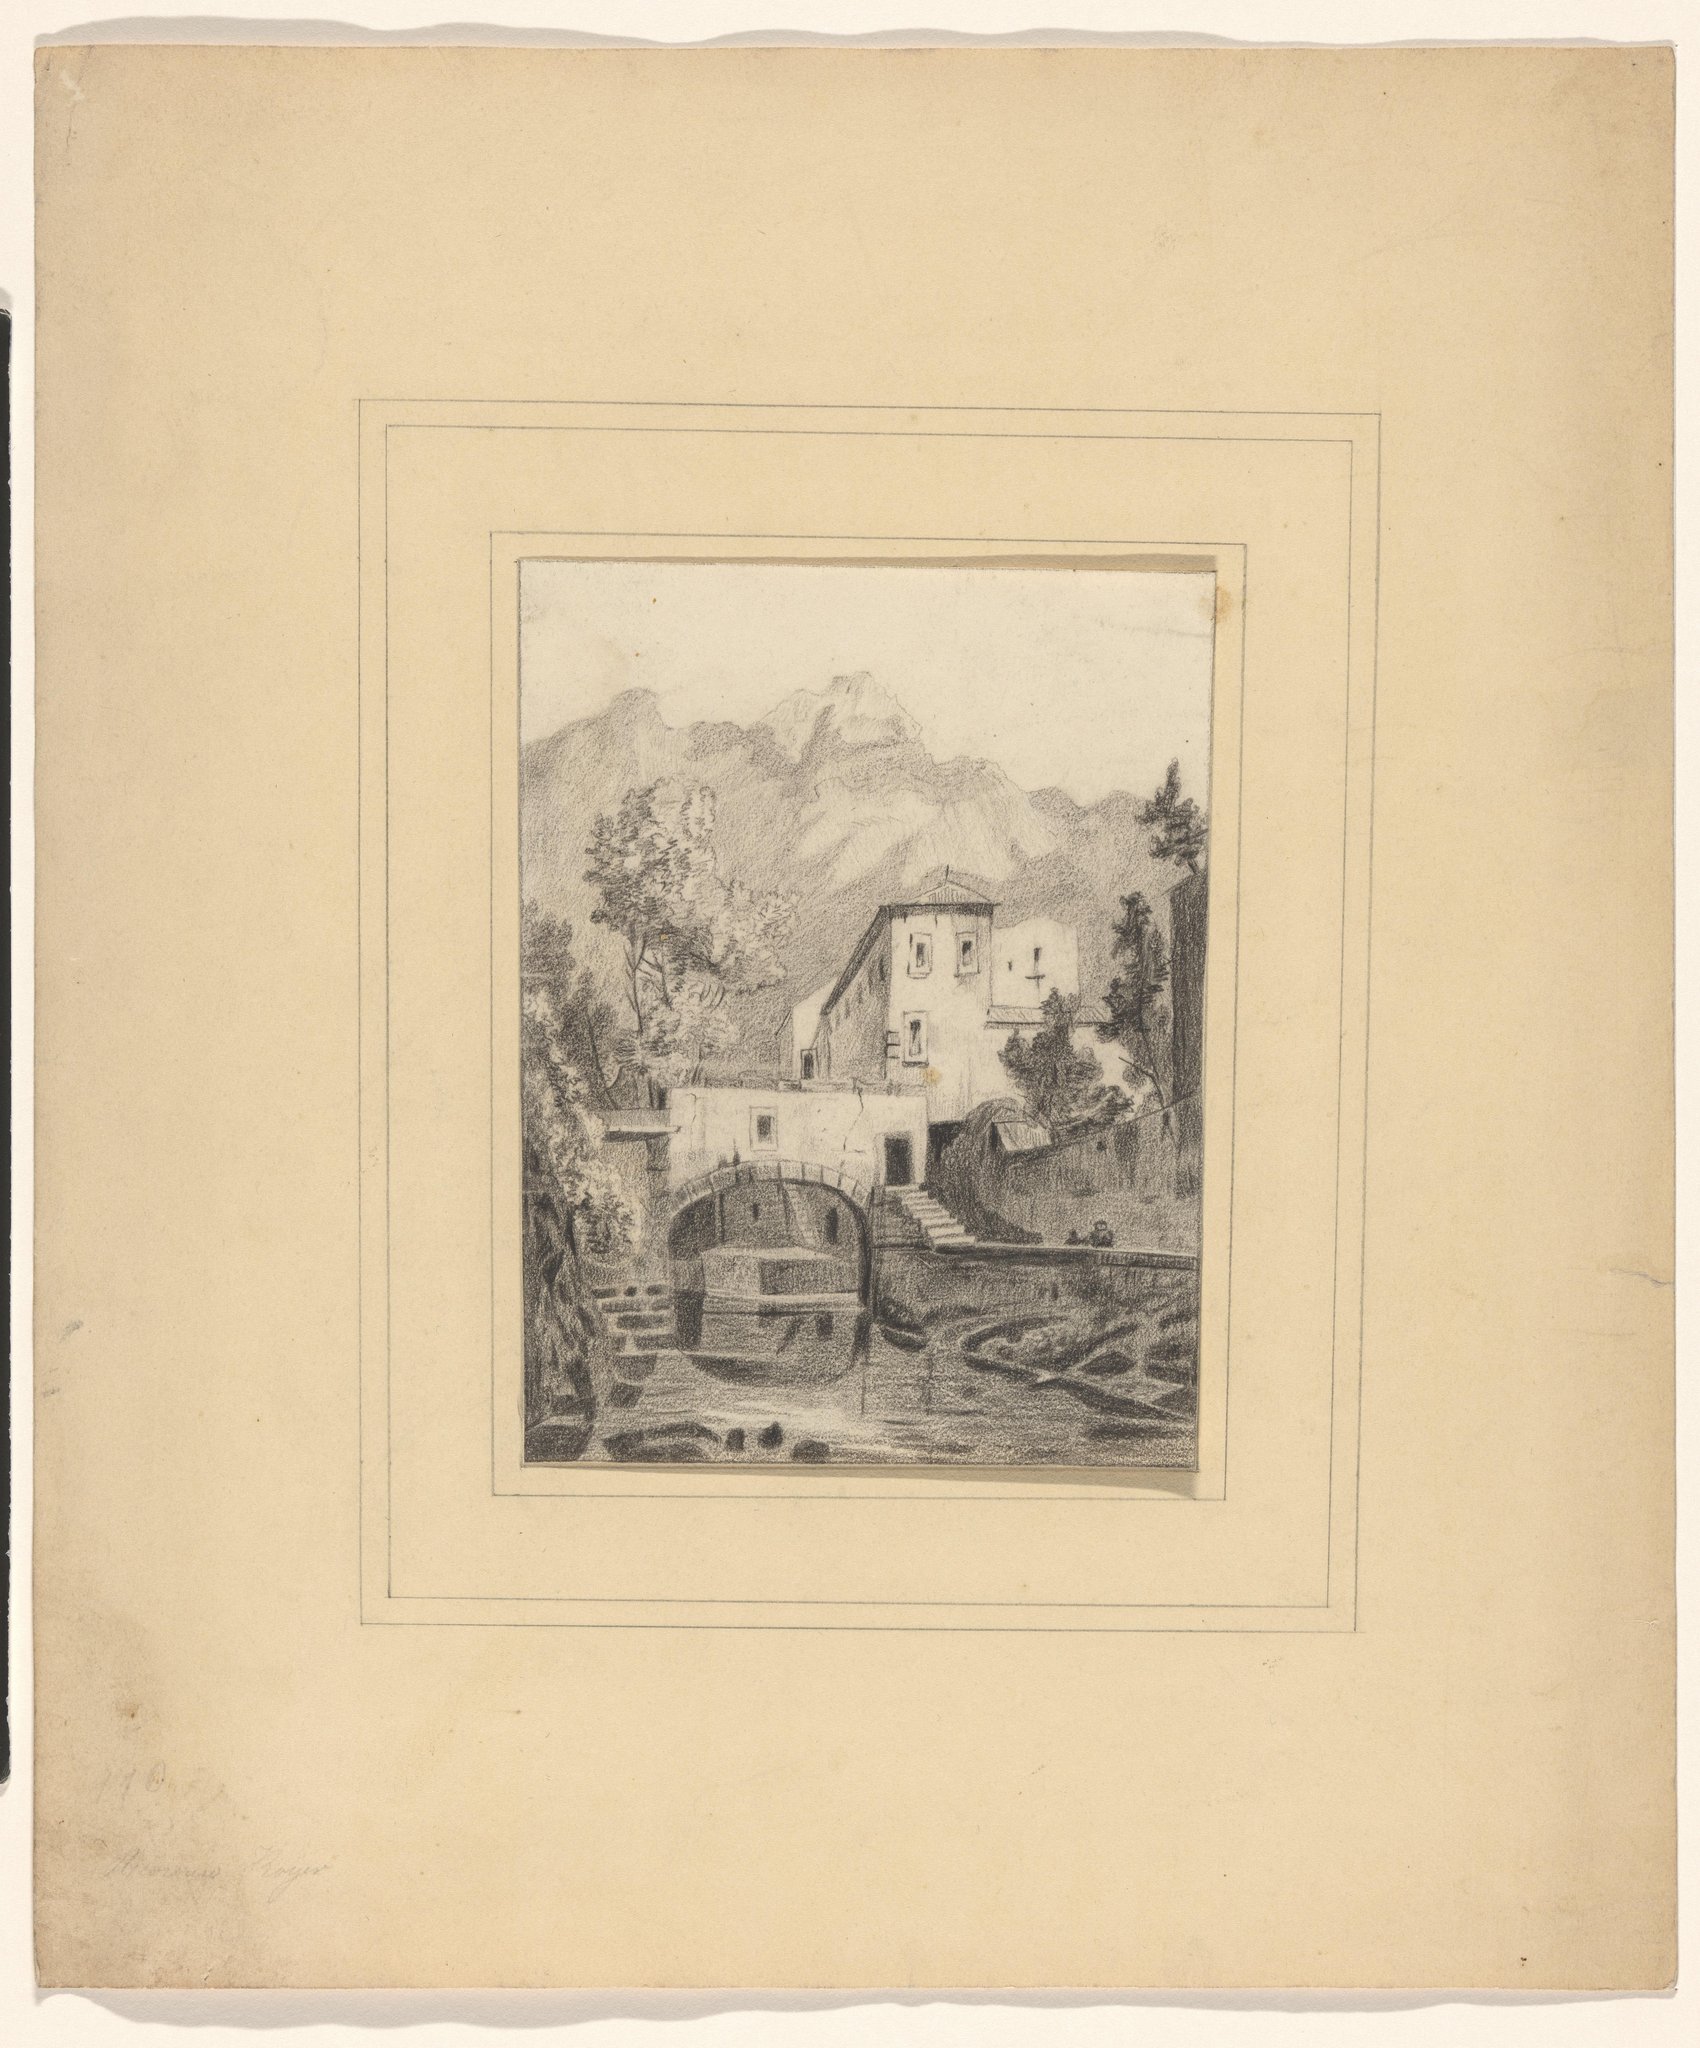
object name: drawing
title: Huis bij een kanaal aan de voet van een berg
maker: cornelis broere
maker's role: painter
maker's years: 1803-1860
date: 1830-1860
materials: chalk, paper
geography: netherlands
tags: carolina frederica royer-kerst, canal, mountains, amalfi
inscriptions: inscription: ‘Vue prise sur la route / d'Amalfi à Cava. / C. Broere / ayant appris 5 mois.’, inscription: ‘110 / Mevrouw Royer’